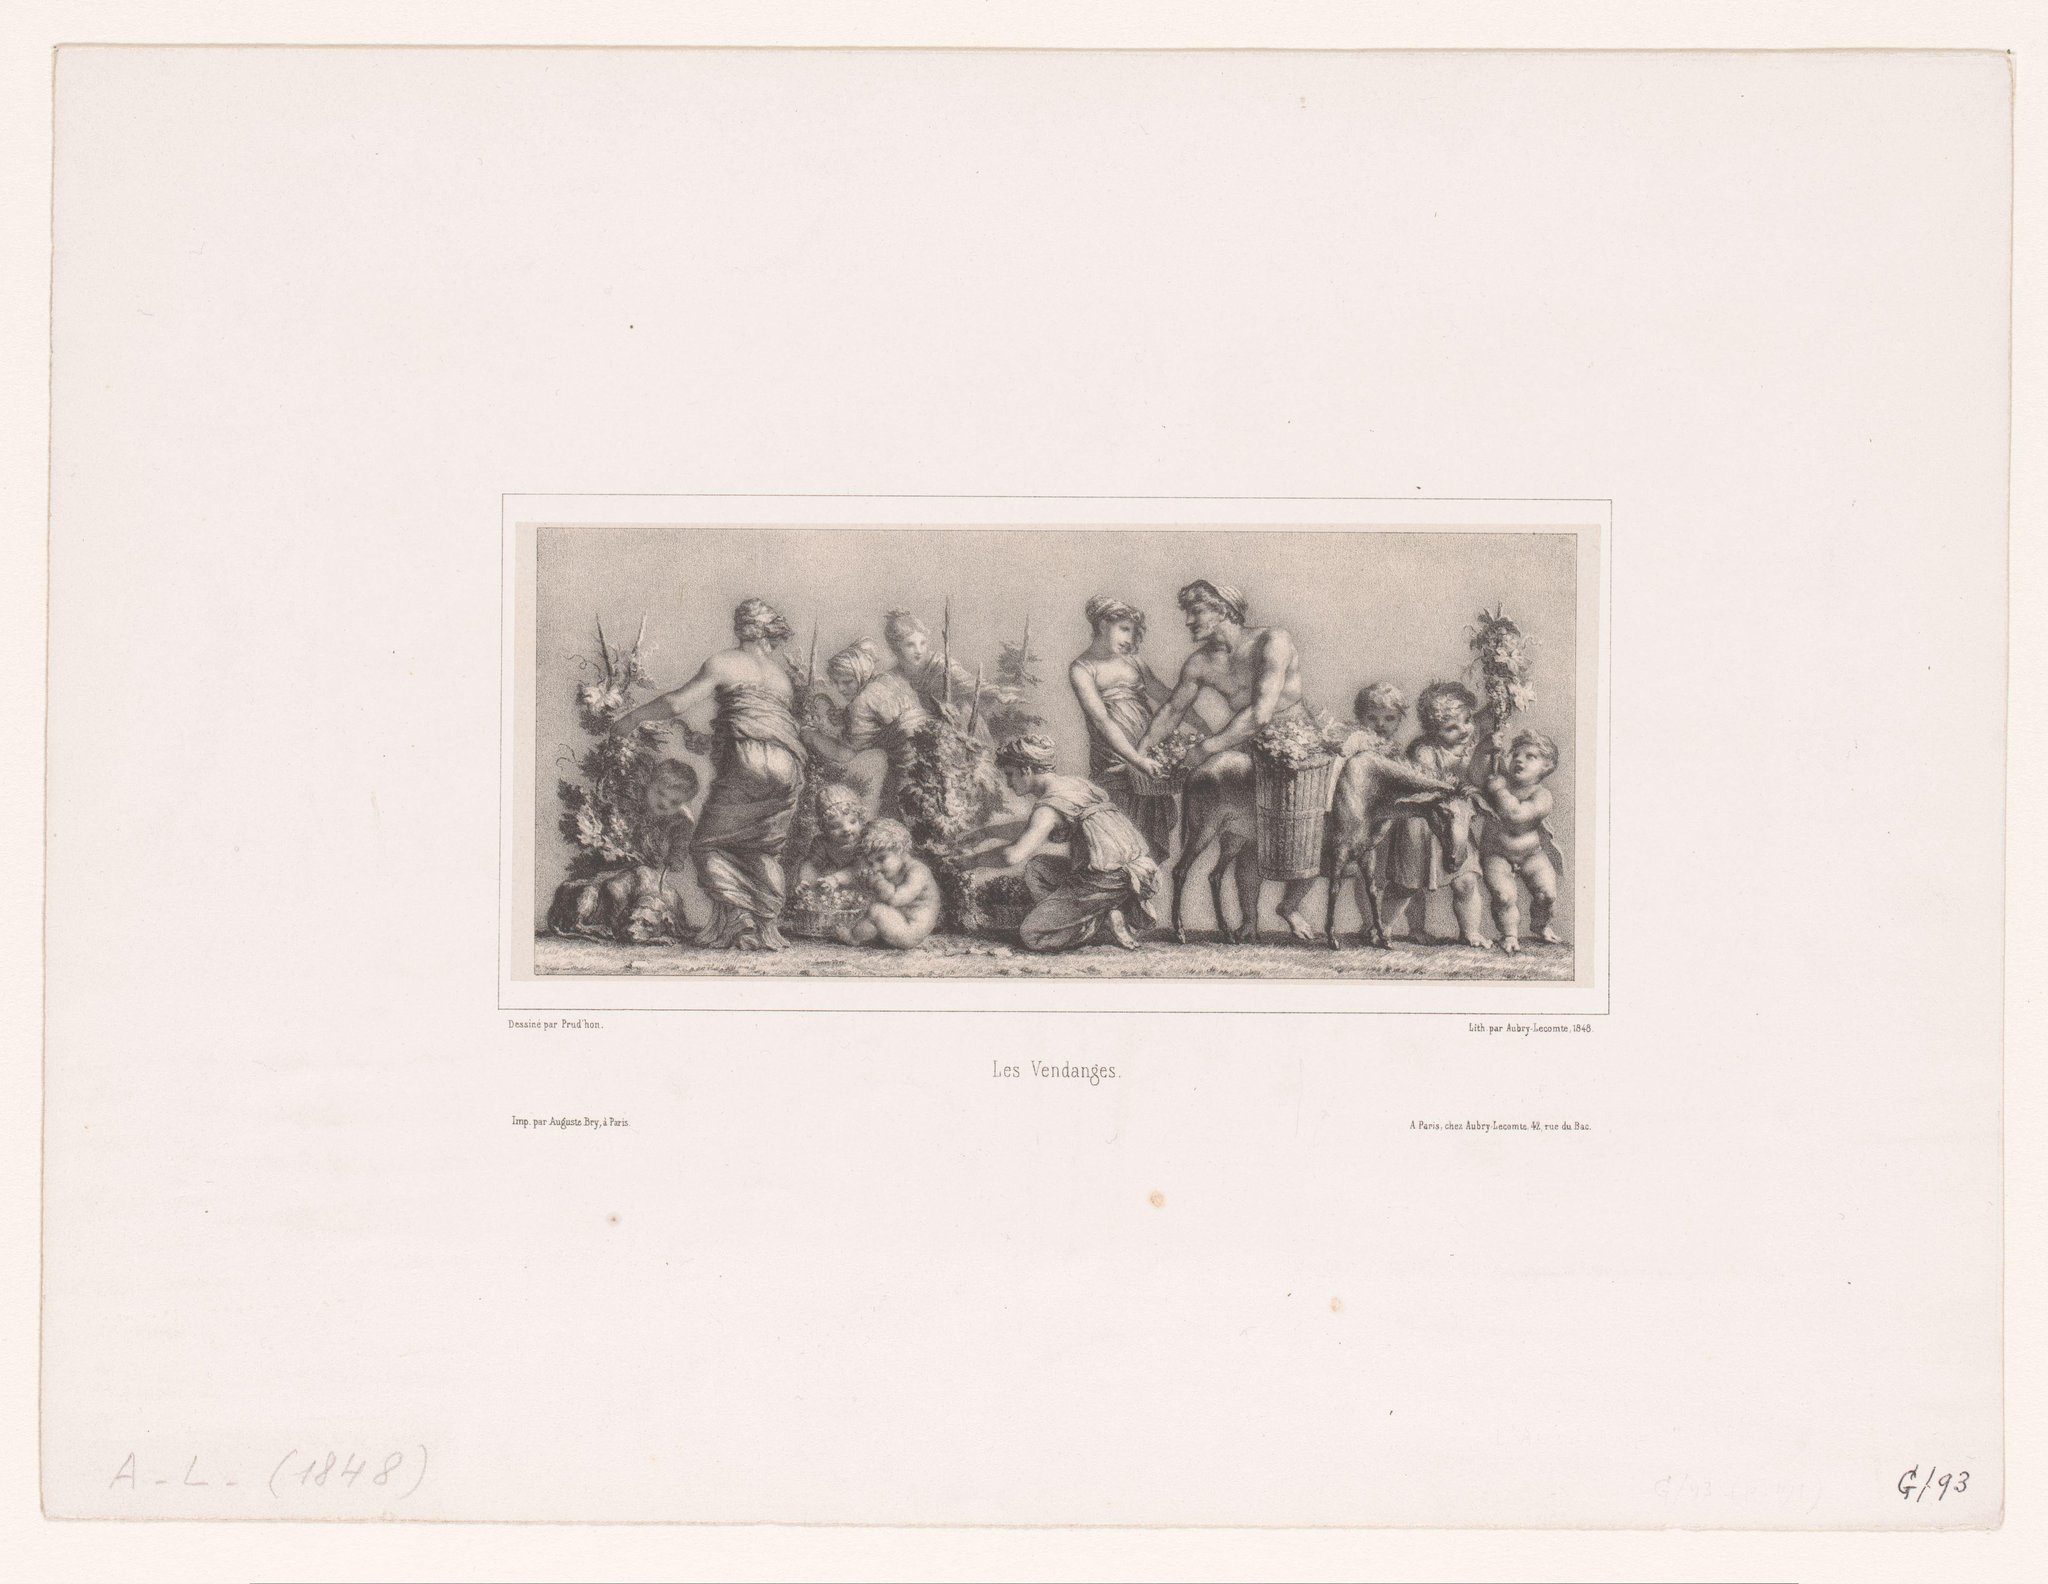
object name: print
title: Les Vendanges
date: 1848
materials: paper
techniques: lithograph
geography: paris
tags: harvest, vintage, grape harvest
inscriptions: collector's mark: Lugt 2228, collector's mark: Lugt 2760